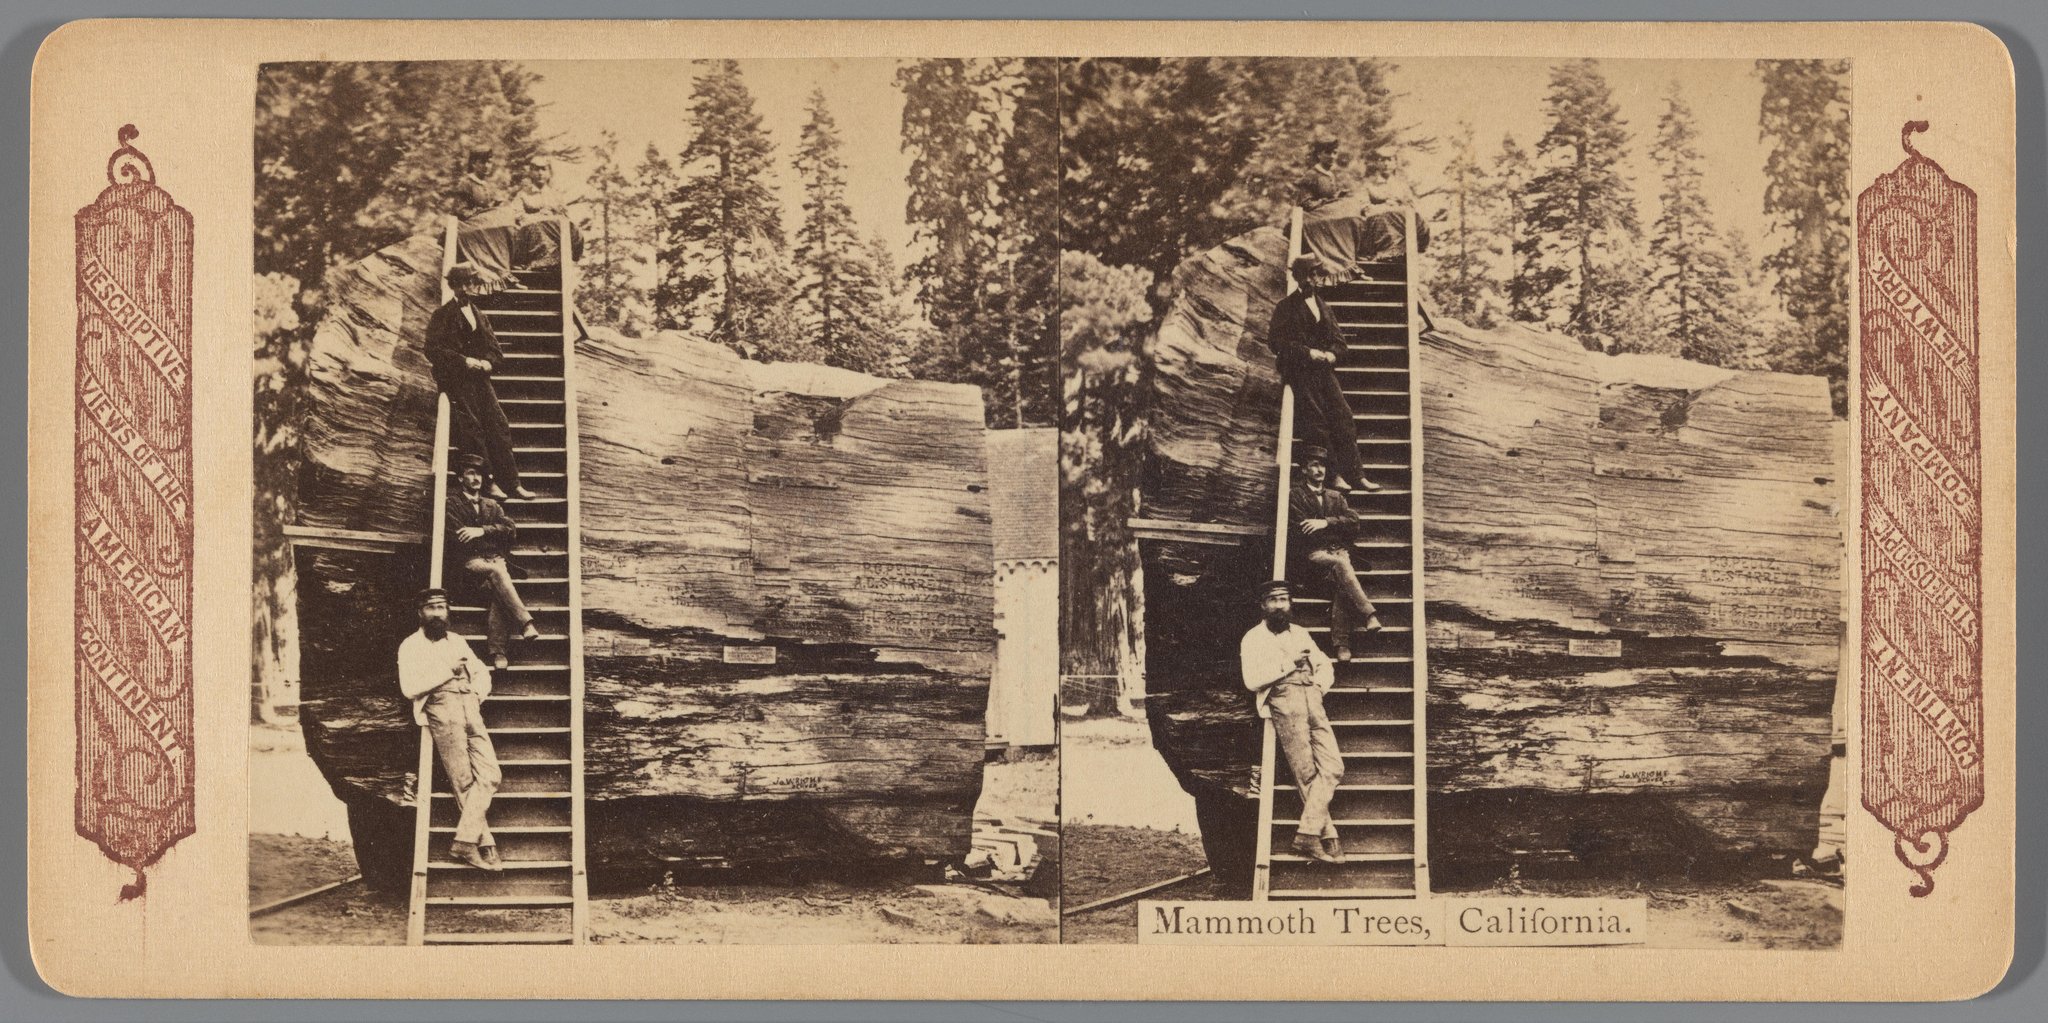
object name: stereograph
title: Descriptive Views of the American Continent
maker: Anonymous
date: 1860-1875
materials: cardboard, photographic support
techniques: albumen print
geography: new york city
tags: californië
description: Drie mannen en twee vrouwen poseren op een ladder die tegen de voet staat van een omgezaagde reuzeboom in Californië.